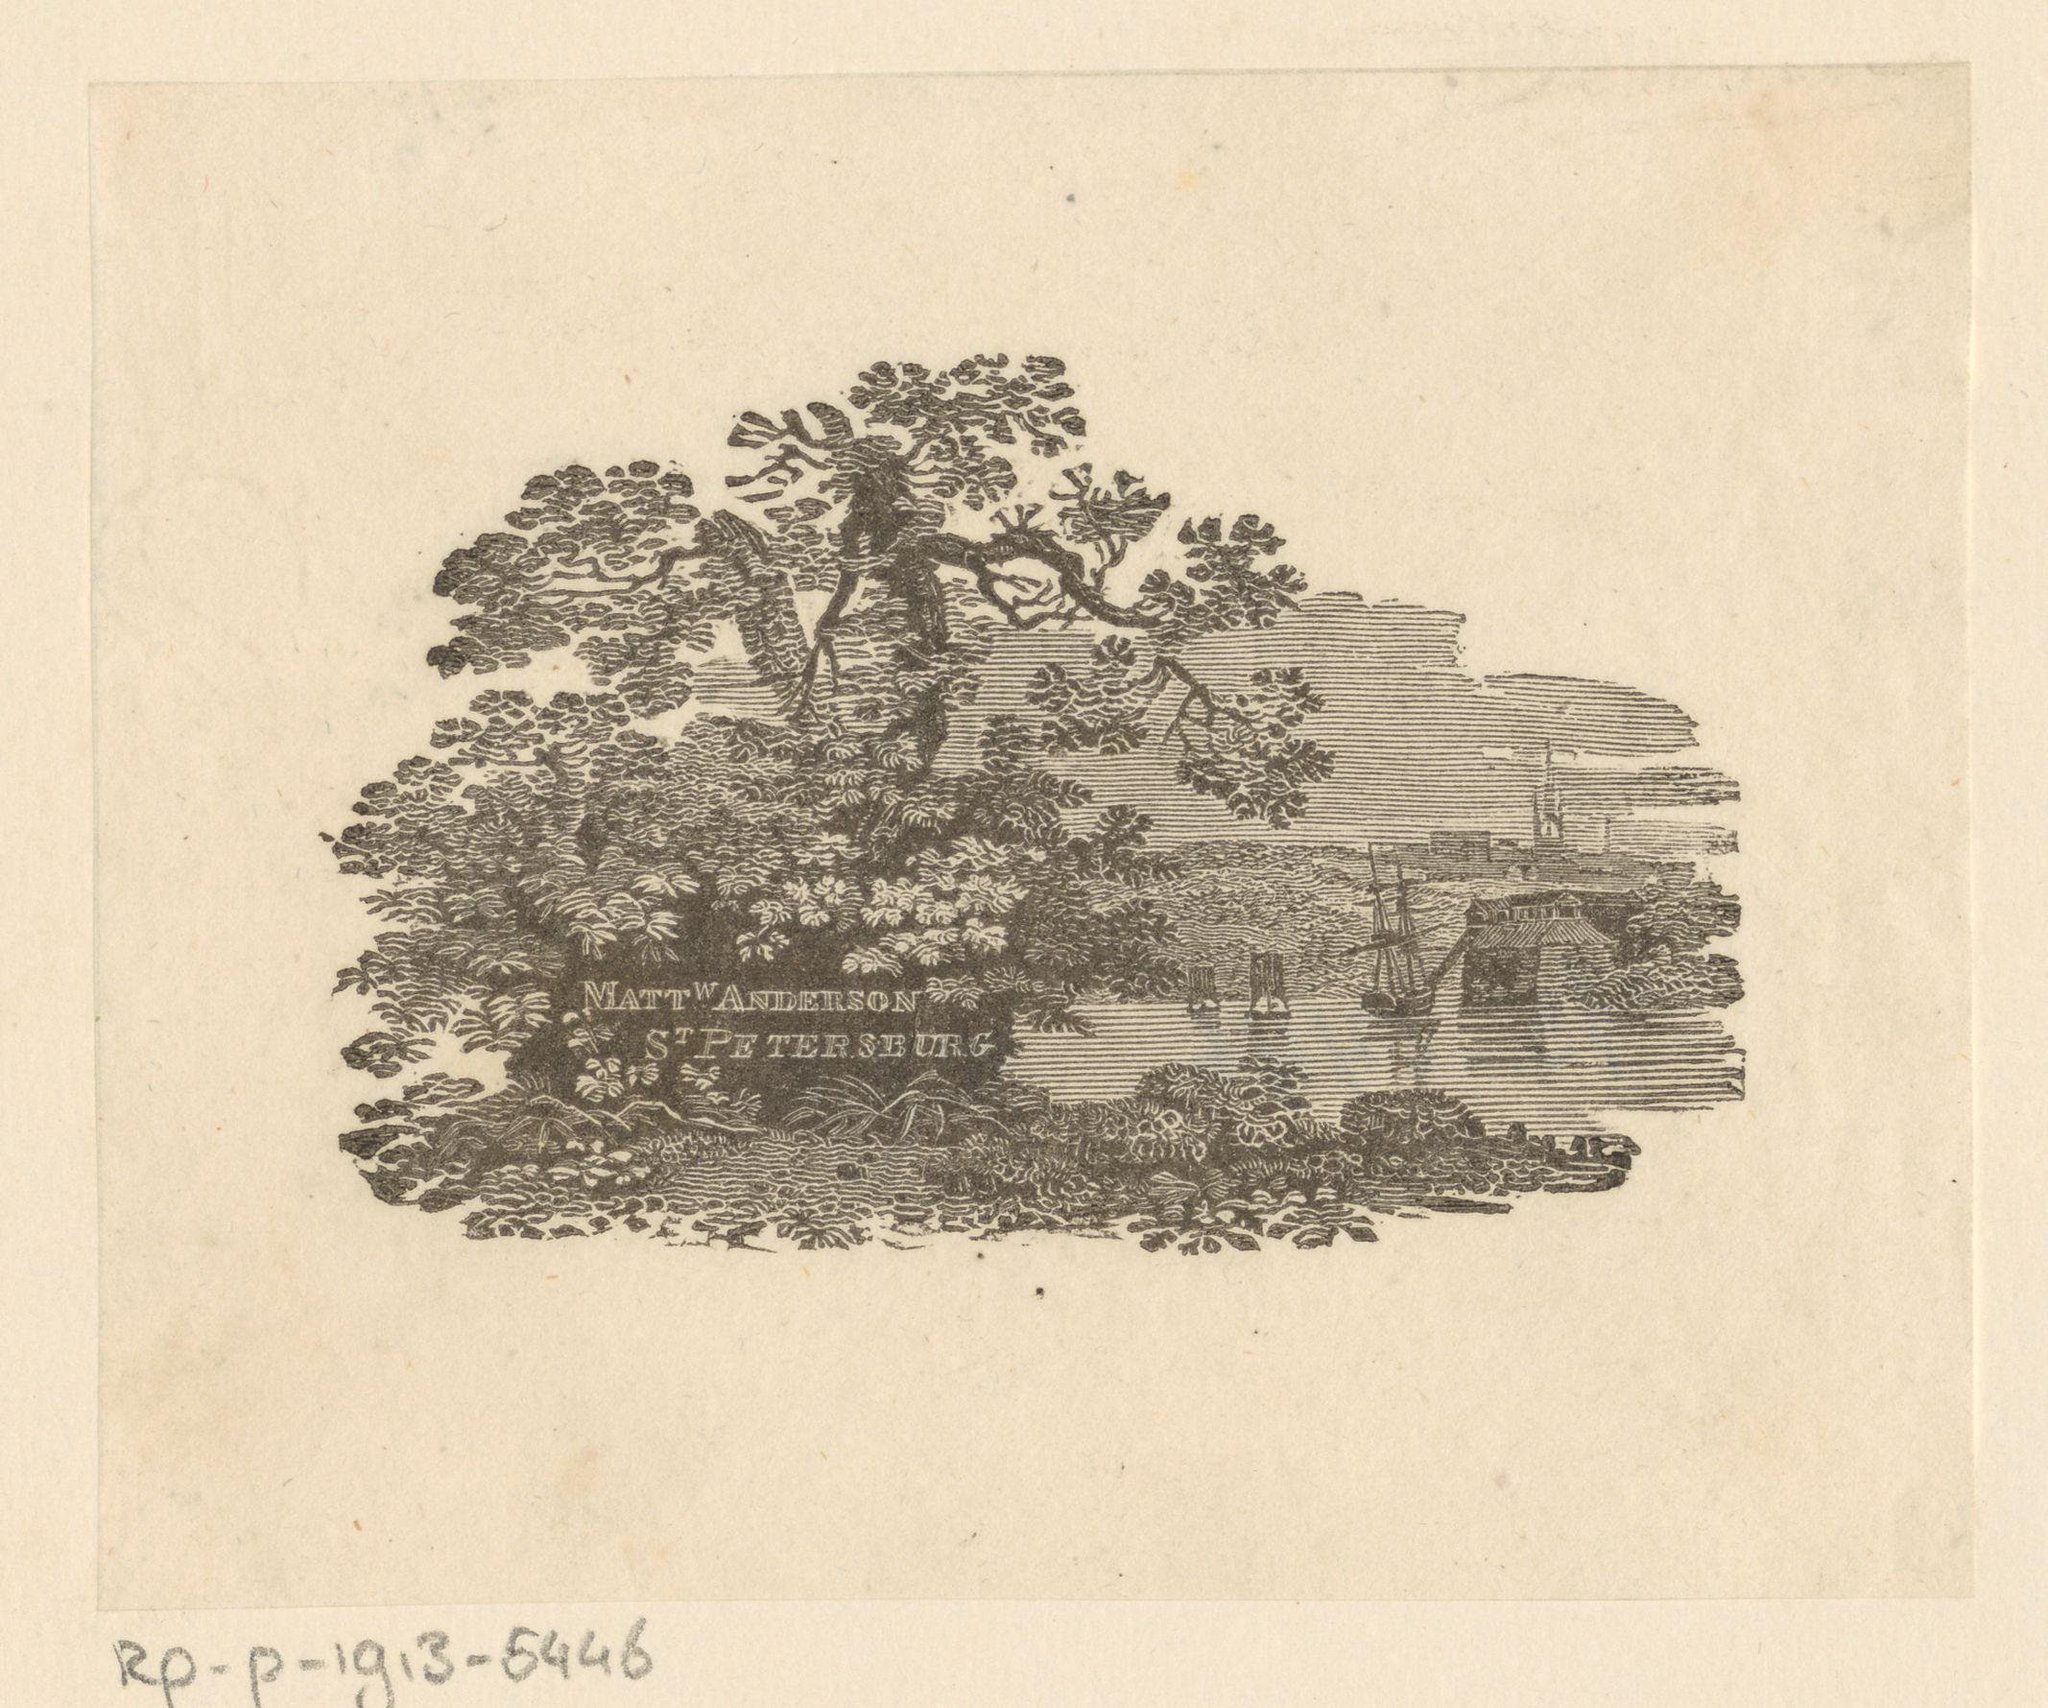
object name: bookplate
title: Ex libris van Matthew Anderson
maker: Anonymous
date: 1800-1899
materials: paper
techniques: engraving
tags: river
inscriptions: collector's mark: Lugt 2760, collector's mark: Lugt 2233